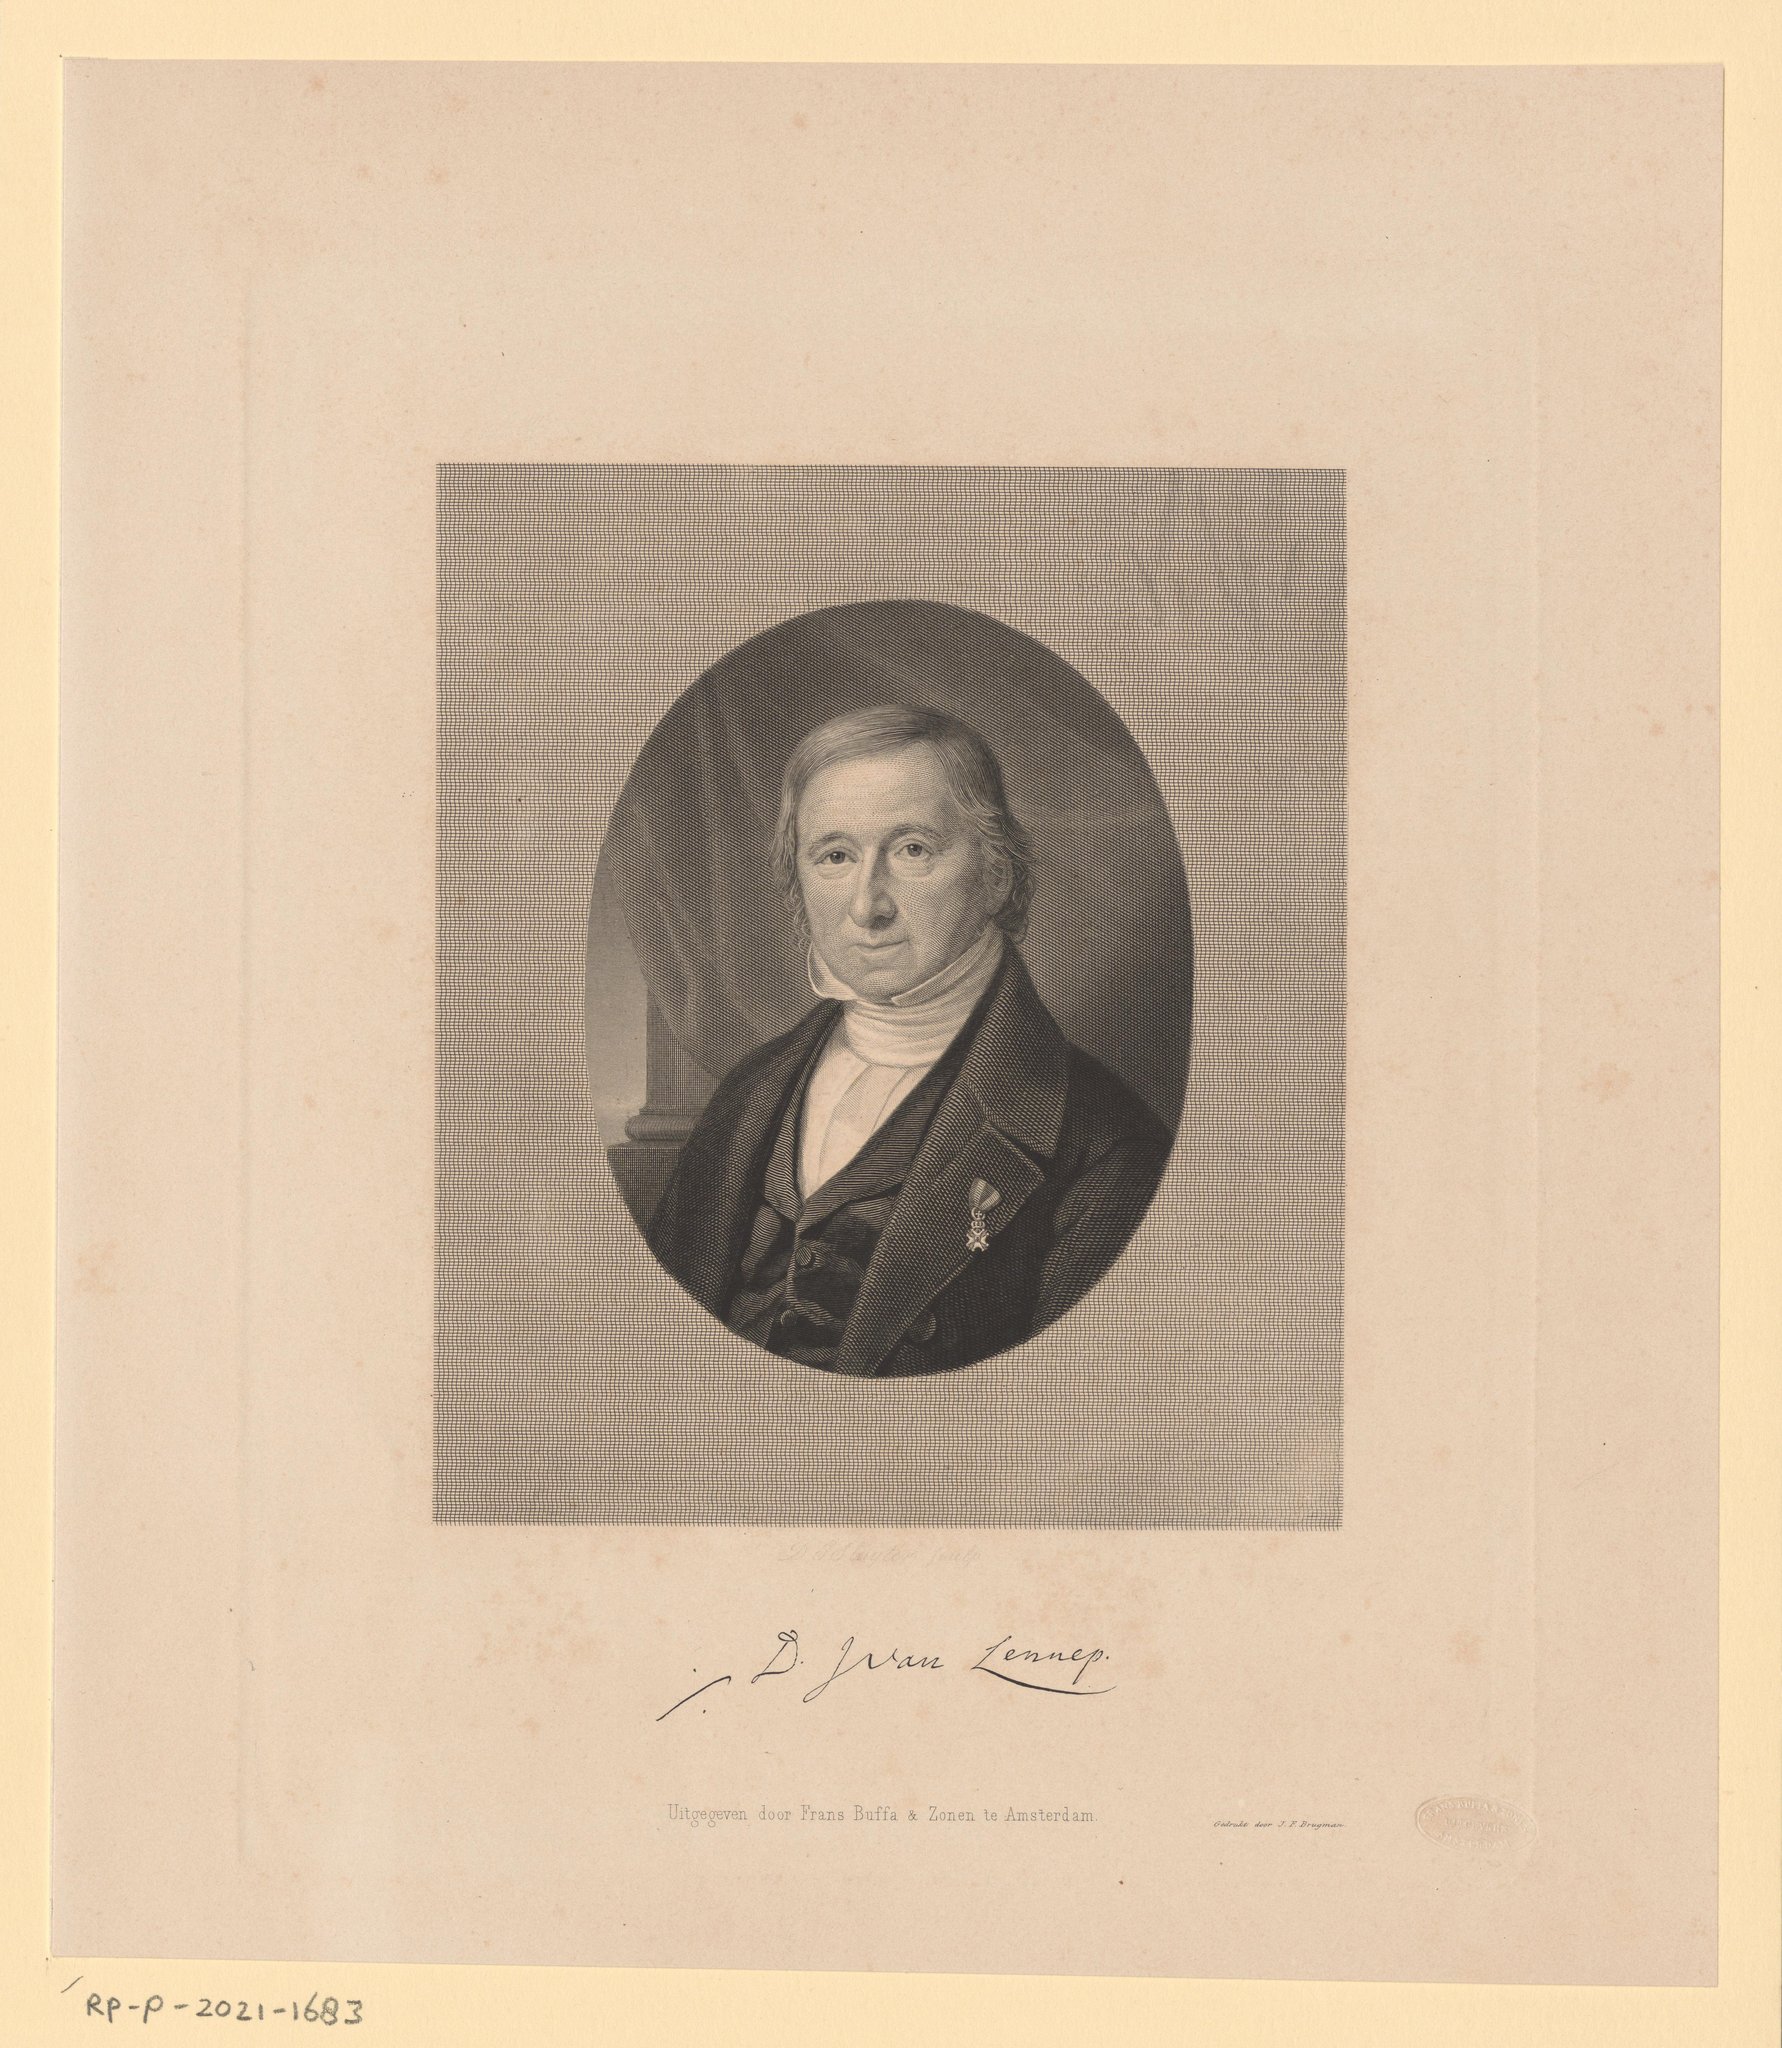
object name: print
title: Portret van David Jacob van Lennep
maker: dirk jurriaan sluyter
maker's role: draughtsman, print maker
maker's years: 1811-1886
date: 1834-1886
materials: paper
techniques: engraving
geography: amsterdam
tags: historical persons, professor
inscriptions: check stamp: ‘Frans Buffa & zonen/ uitgevers/ Amsterdam’